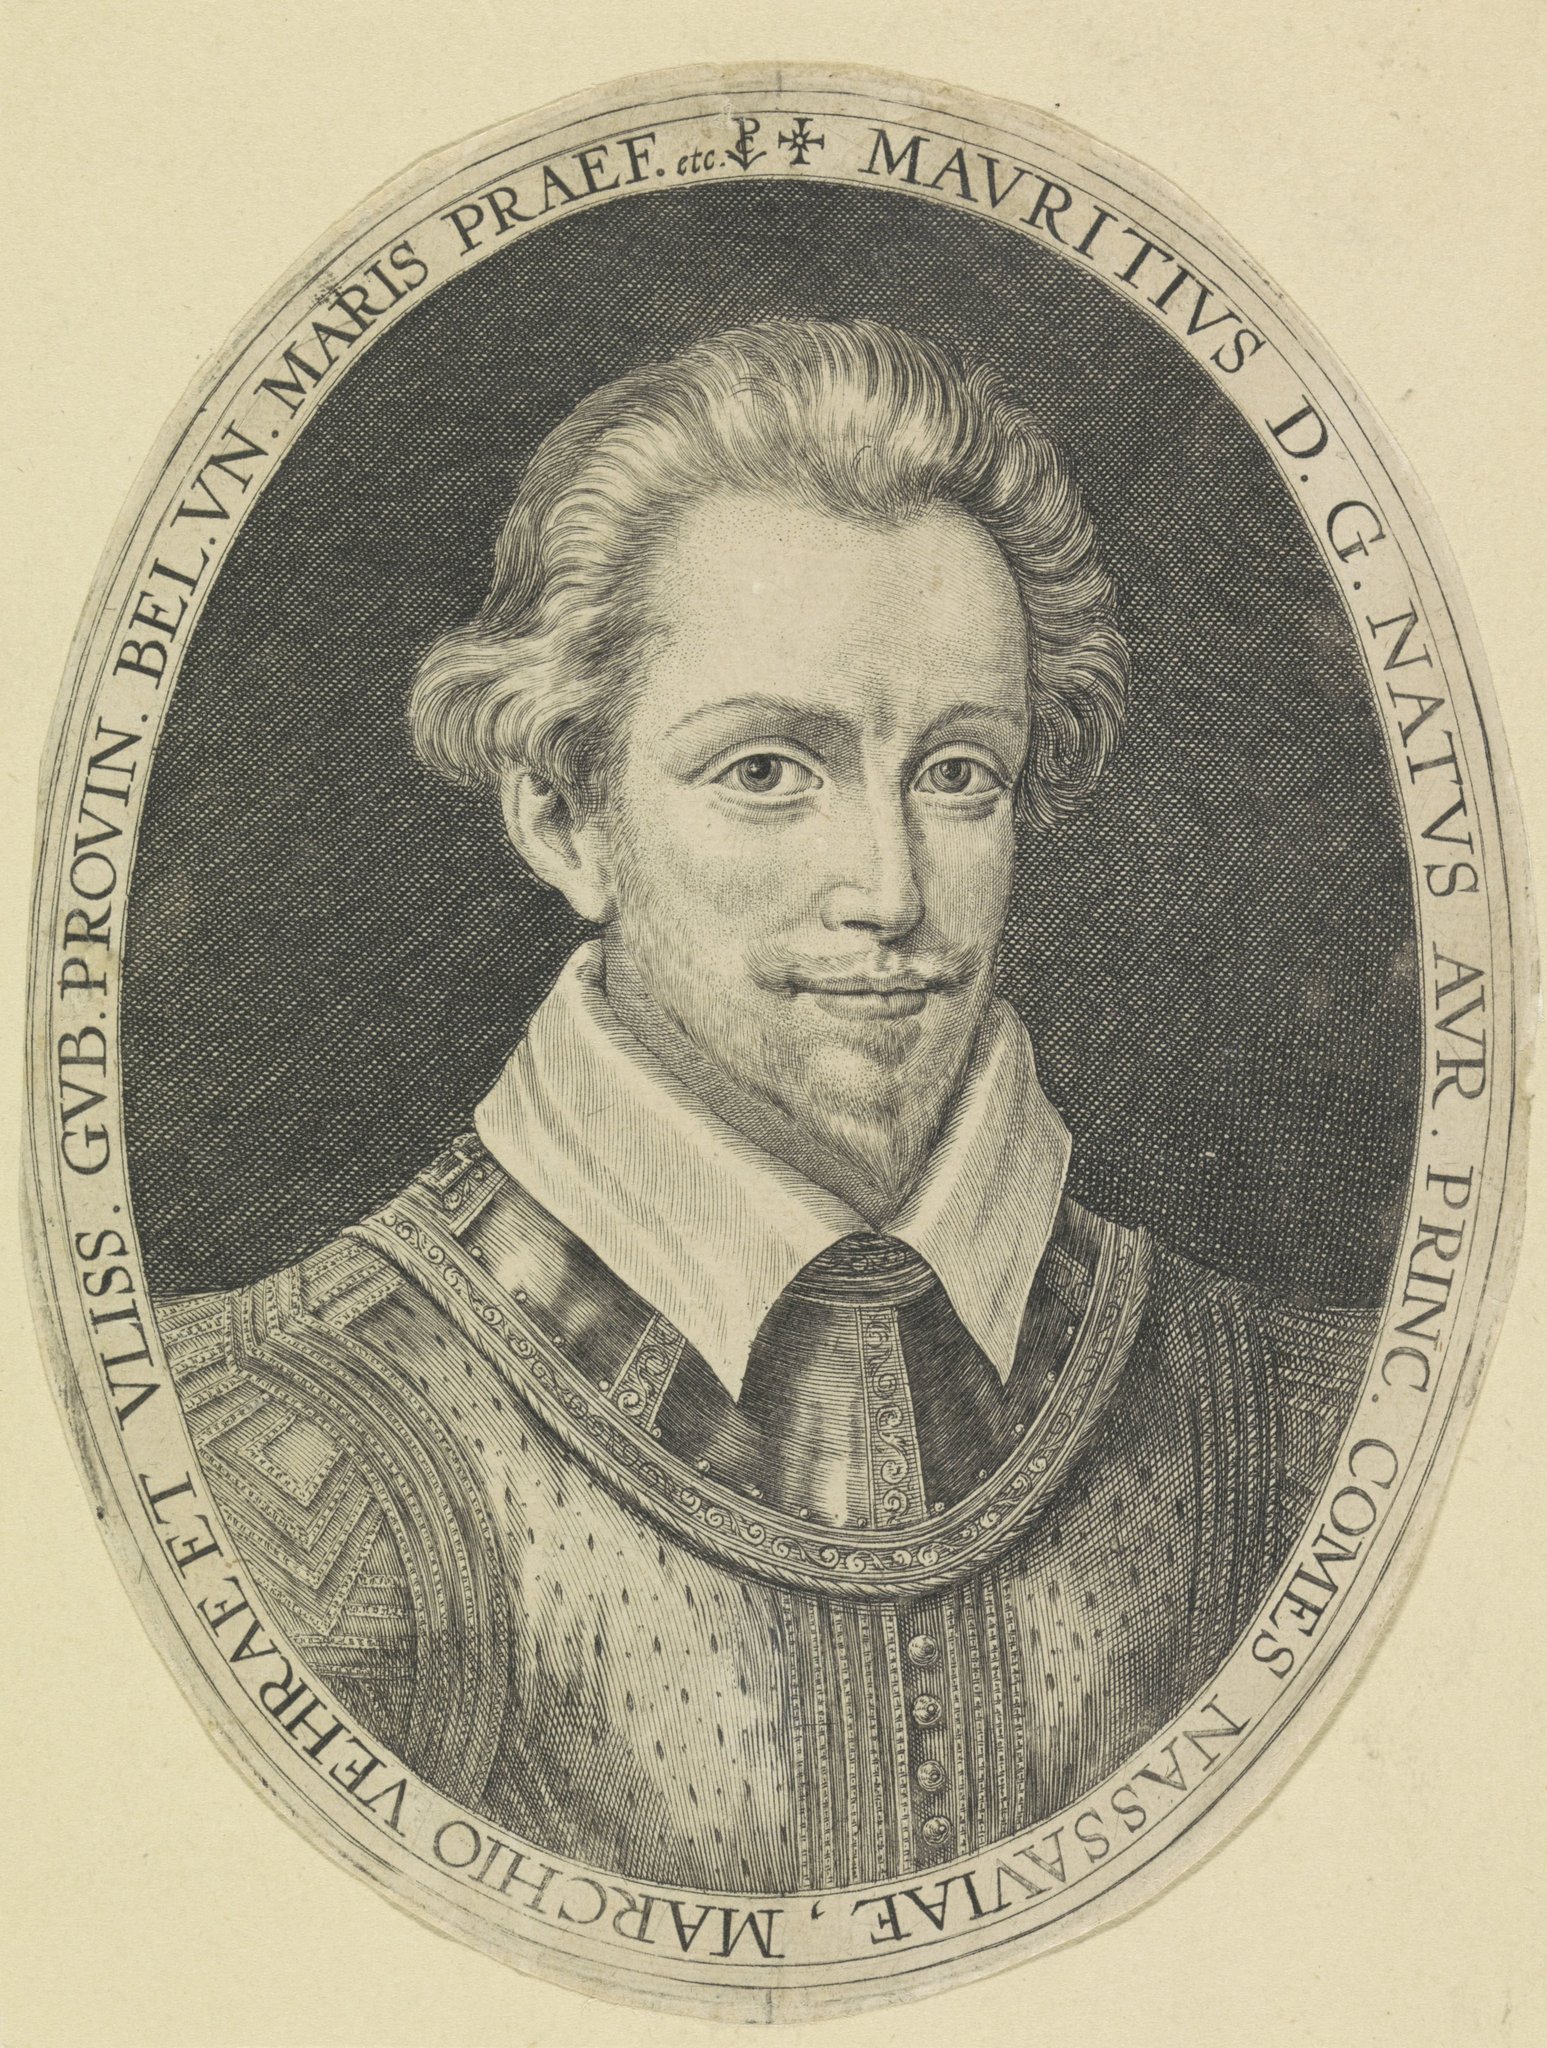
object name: print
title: Portret van Maurits, prins van Oranje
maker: crispijn van de passe (i)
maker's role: draughtsman, print maker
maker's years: 1564-1637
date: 1597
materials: paper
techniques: engraving, etching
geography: cologne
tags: the hague, maurice (prince of orange)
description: De hier vermelde titel verwijst naar de hoogst verkregen titel van de geportretteerde, niet per se naar de titel die de geportretteerde op deze voorstelling draagt.